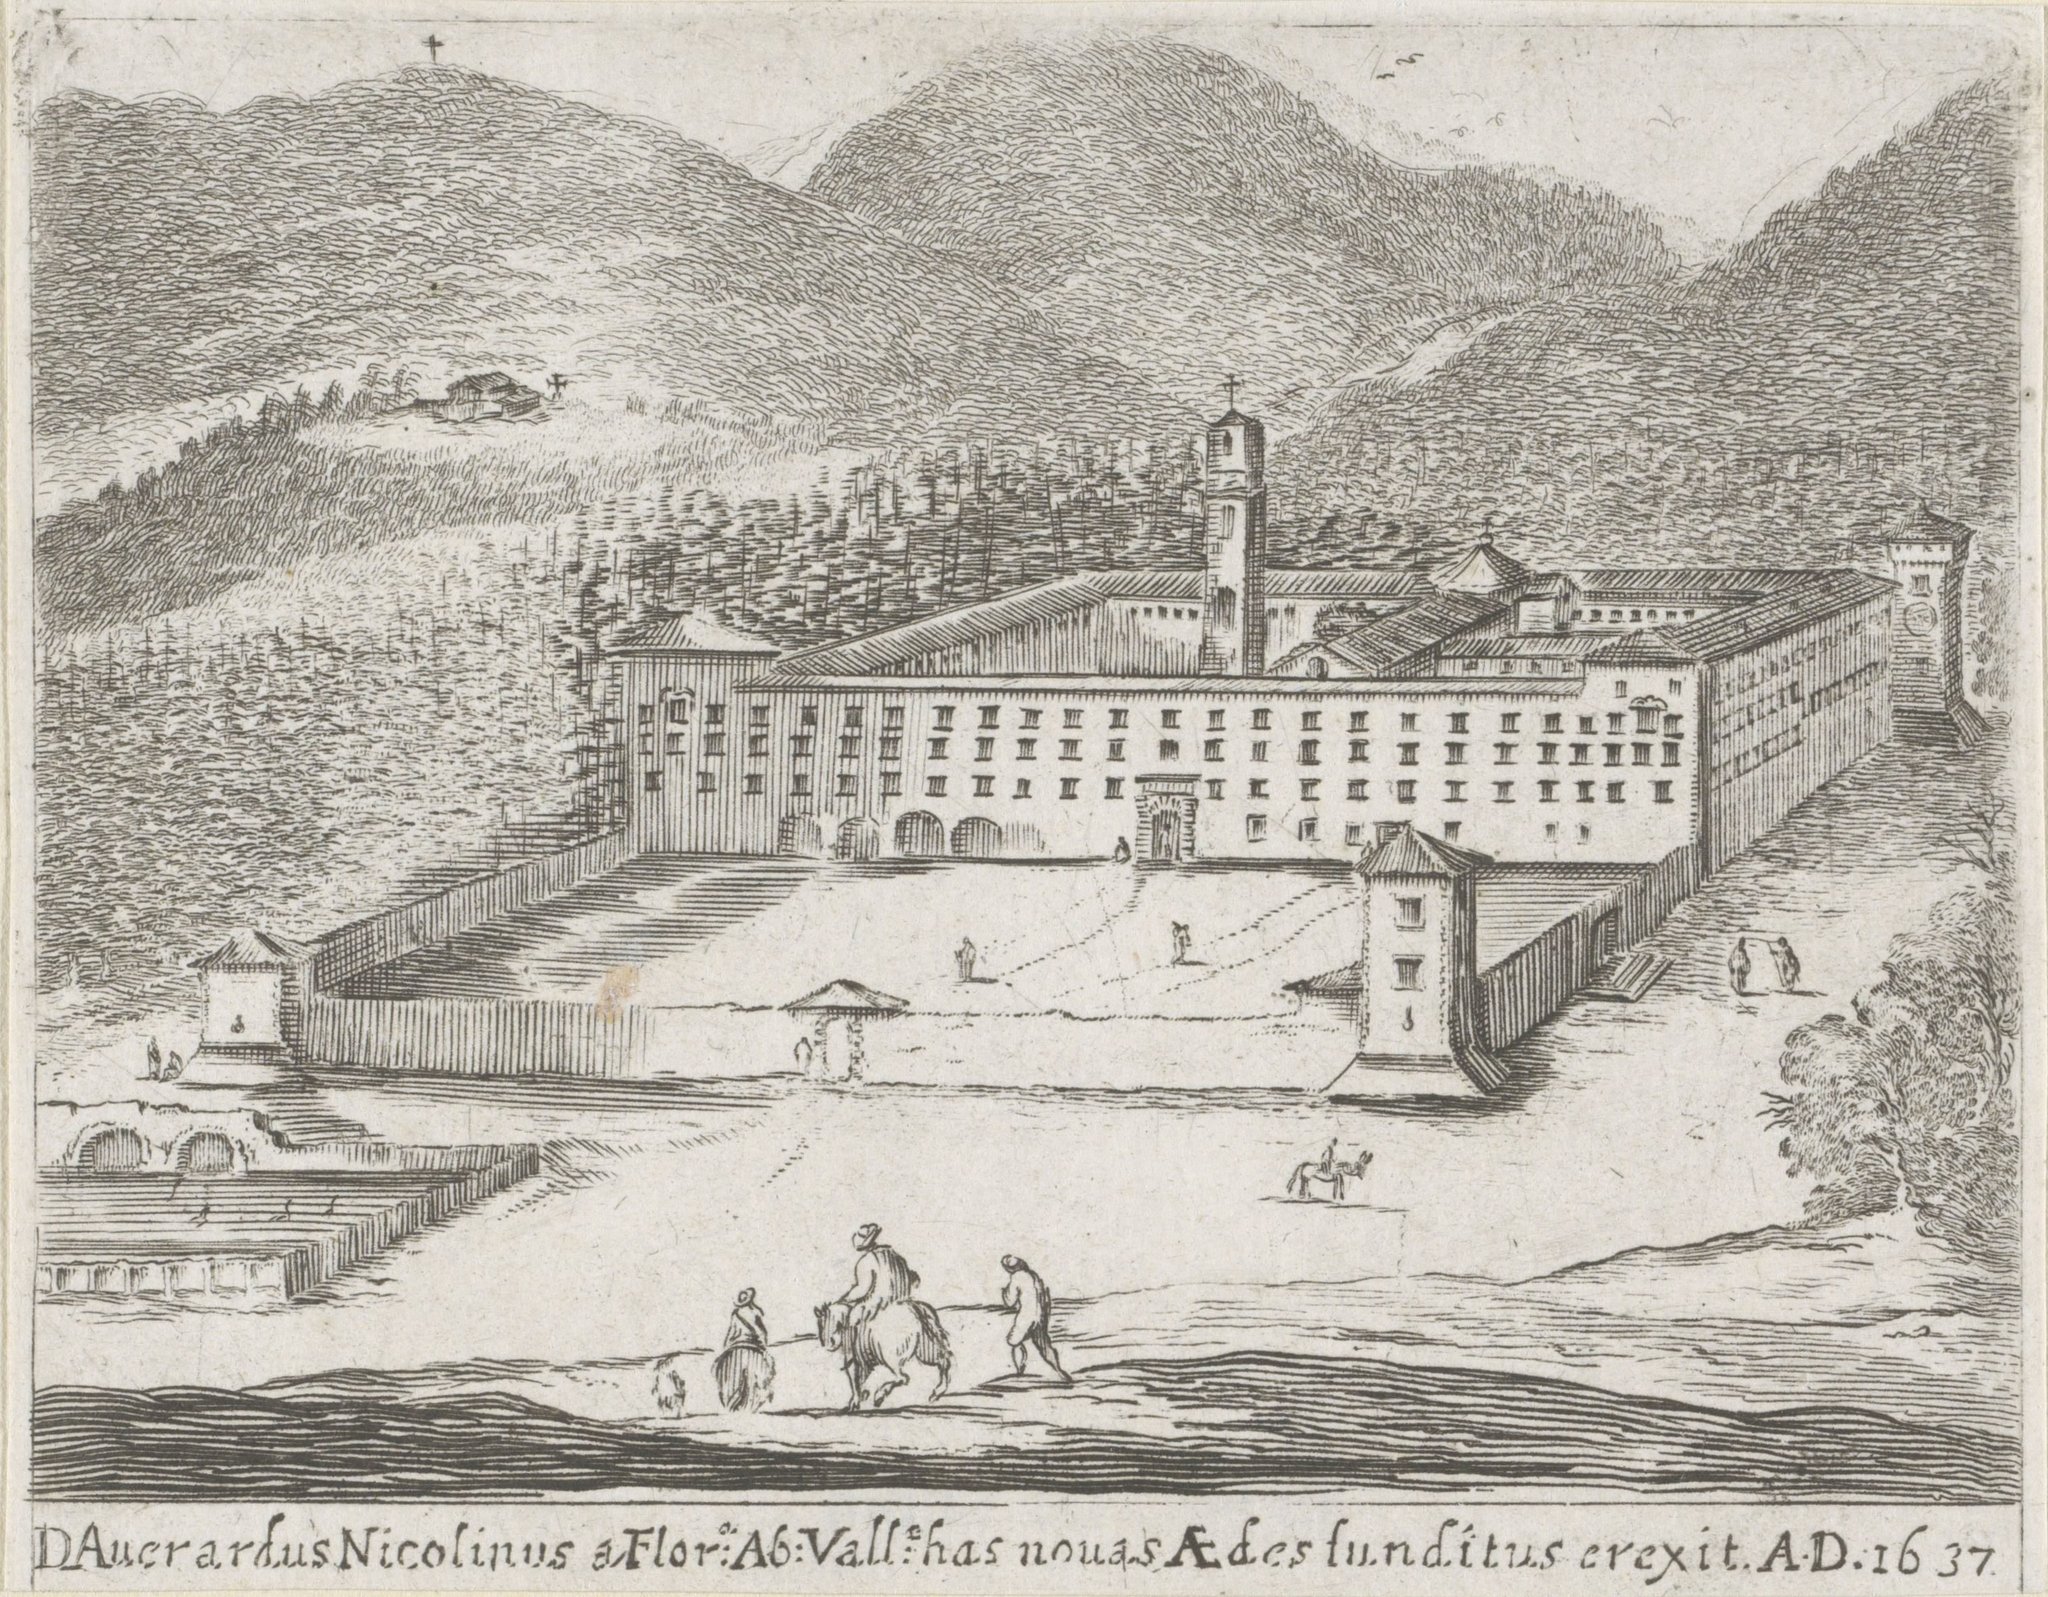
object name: print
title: Leven van de heilige Johannes Gualbertus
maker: stefano della bella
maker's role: draughtsman, print maker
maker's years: 1610-1664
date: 1637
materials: paper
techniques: etching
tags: cloisters ~ monastery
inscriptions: collector's mark: Lugt 240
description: Gezicht op het klooster Vallombrosa (Abbazia di Vallombrosa) in de zeventiende eeuw. Het klooster werd gesticht door de heilige Johannes Gualbertus in 1038.